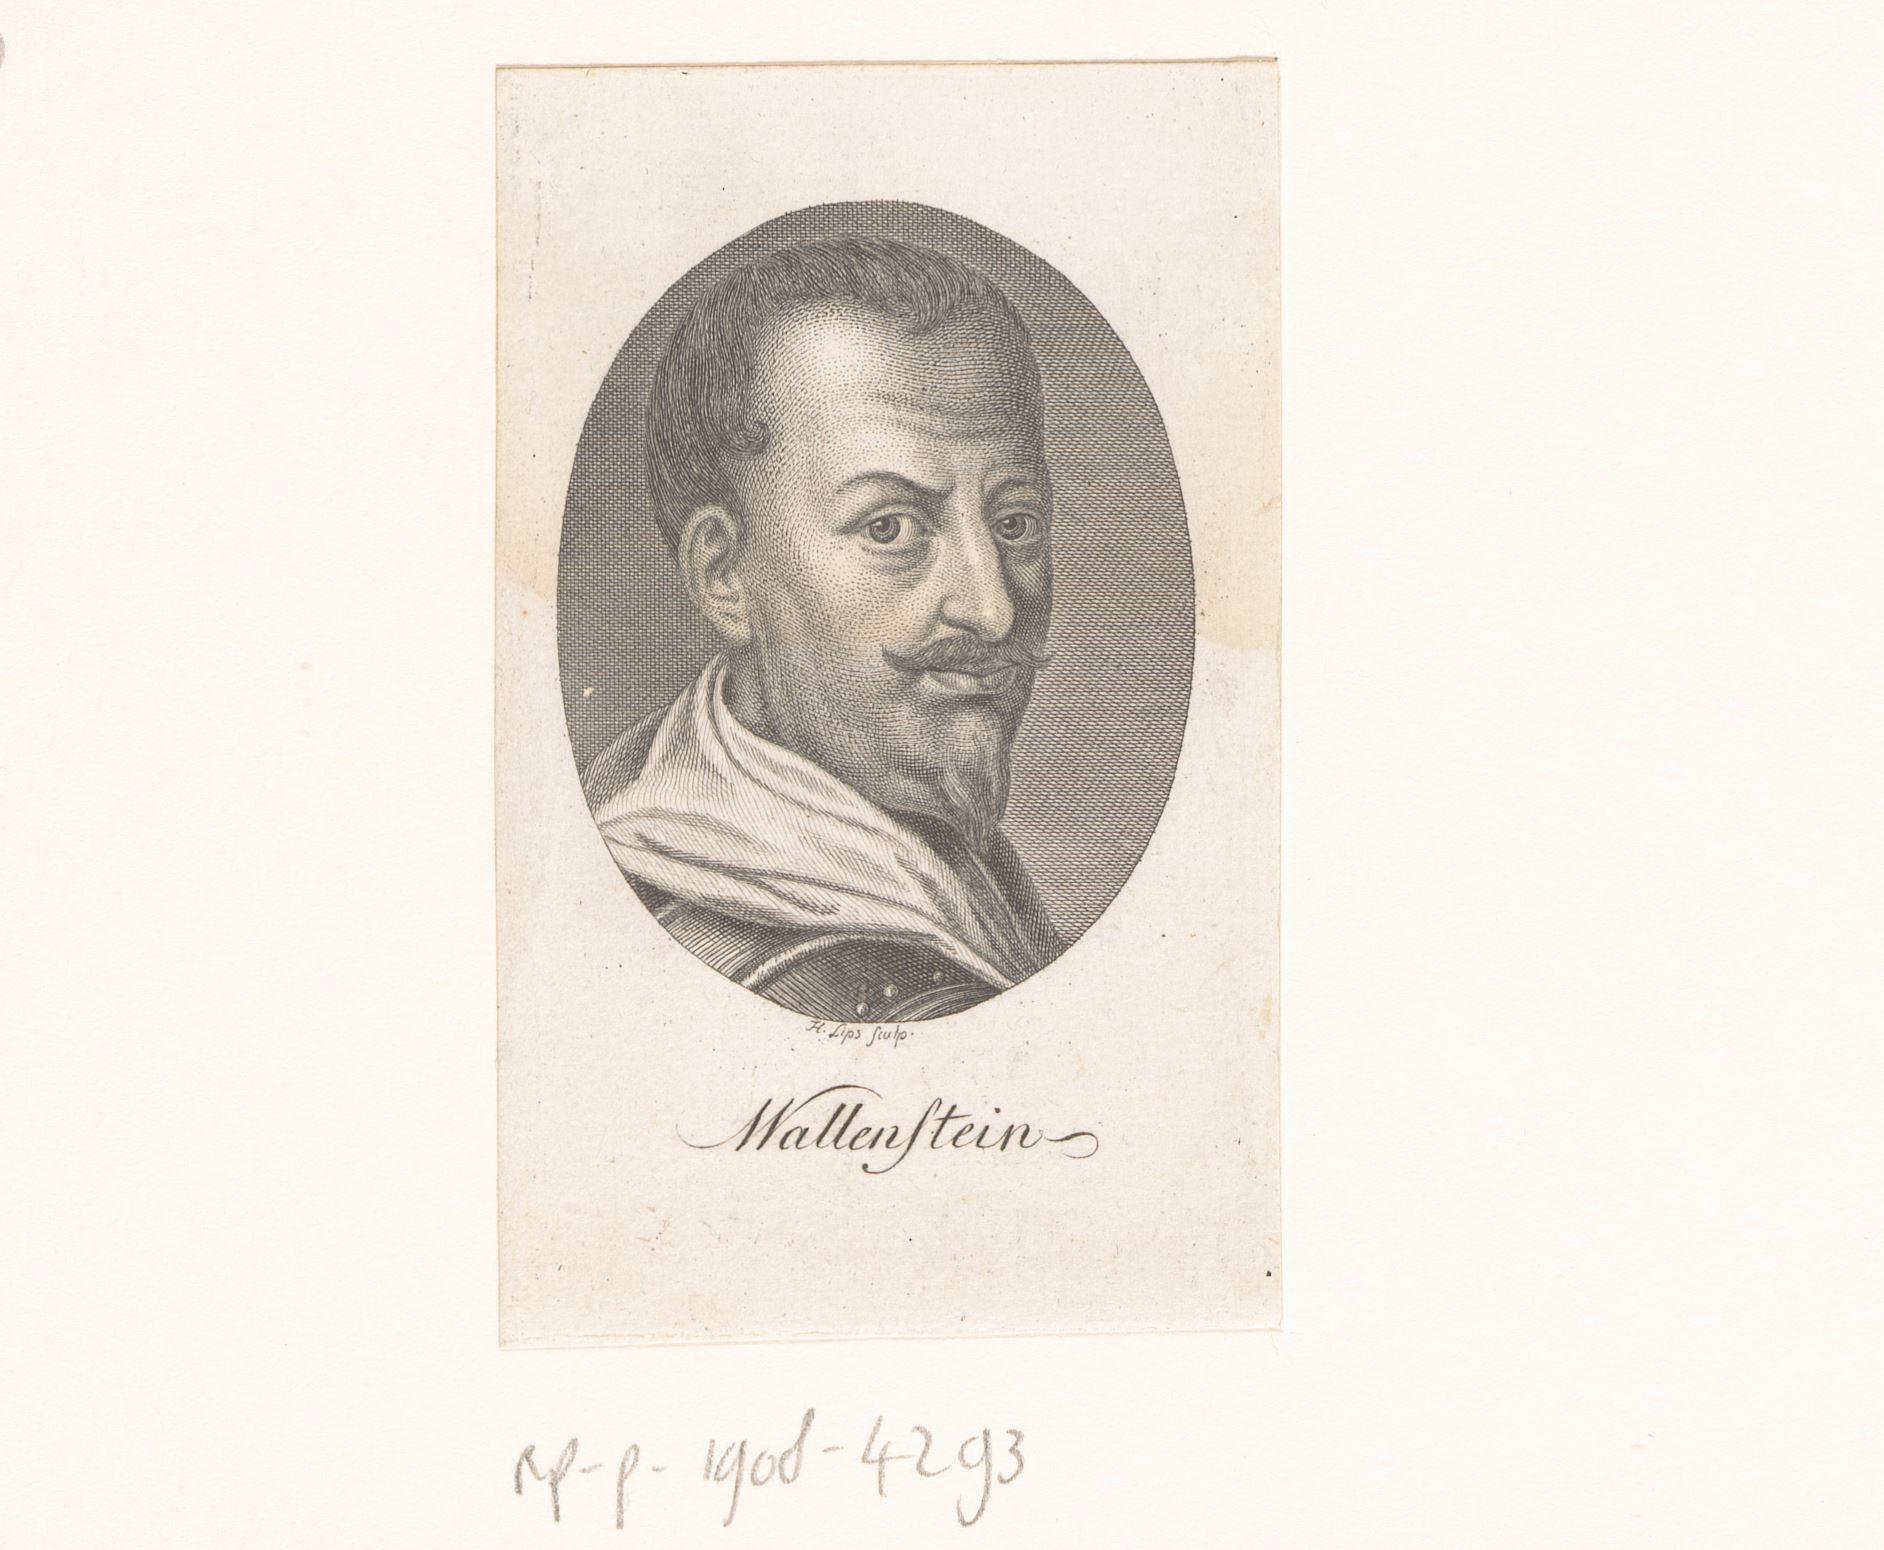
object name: print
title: Portret van Albrecht von Wallenstein, hertog van Friedland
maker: johann heinrich lips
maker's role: draughtsman, painter, print maker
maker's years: 1758-1817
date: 1768-1817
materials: paper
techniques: engraving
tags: armour, historical persons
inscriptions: collector's mark: Lugt 2228